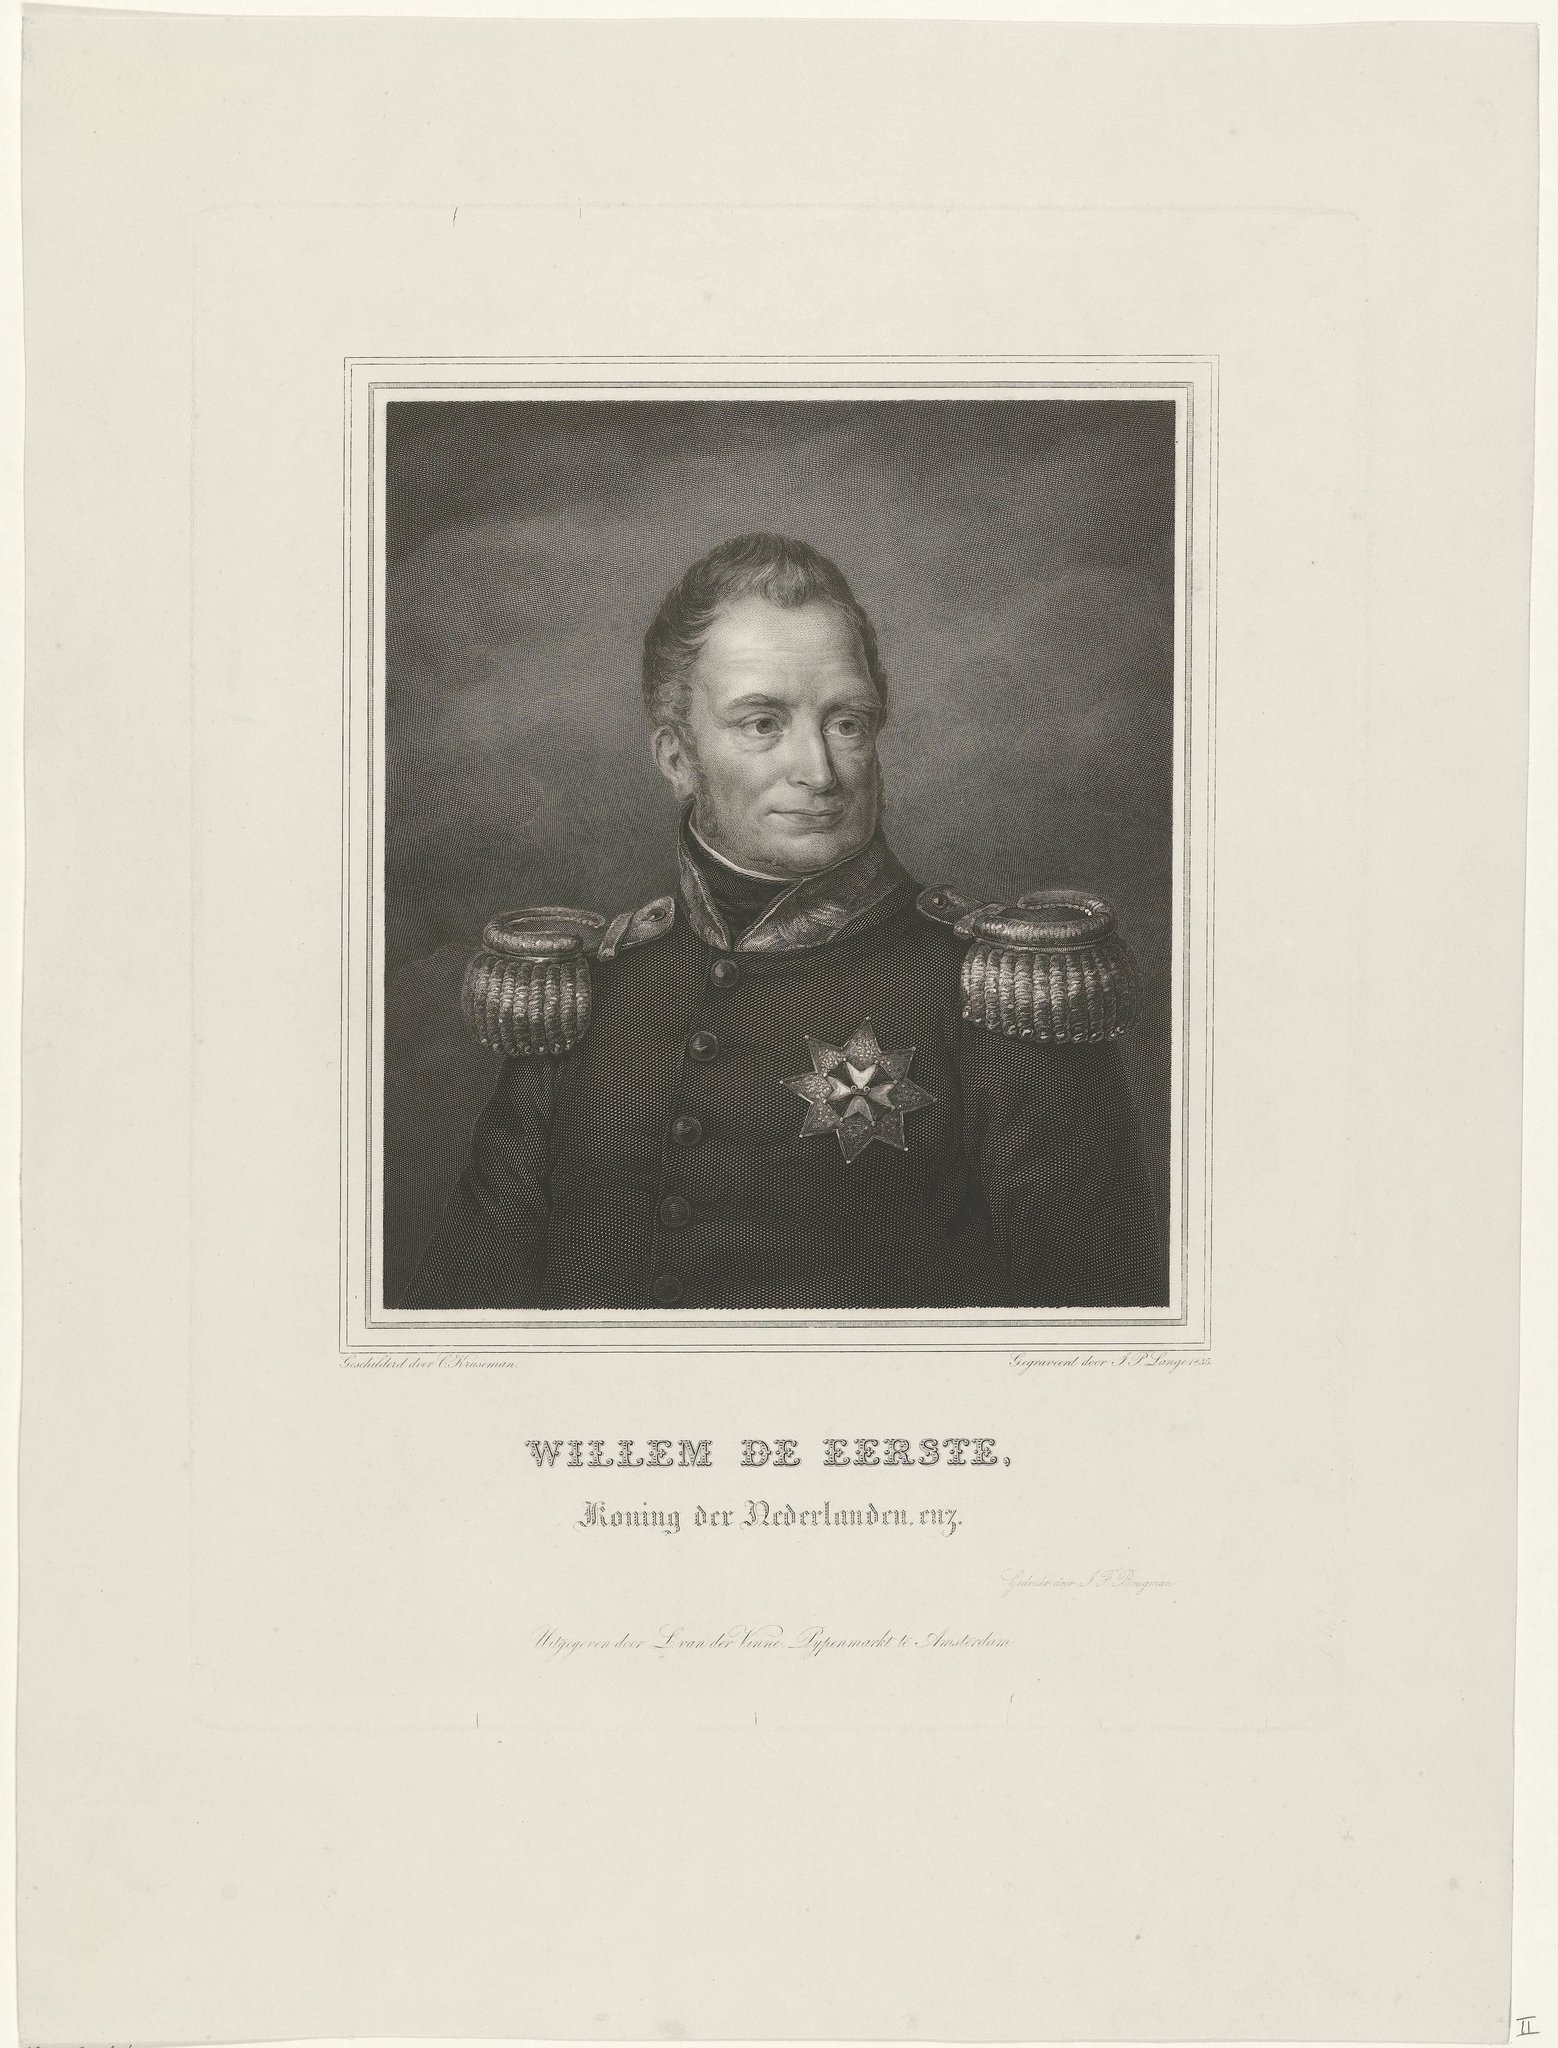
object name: print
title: Willem de Eerste, Koning der Nederlanden, enz.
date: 1835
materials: paper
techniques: engraving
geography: amsterdam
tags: william i of the netherlands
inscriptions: collector's mark: Lugt 2228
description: Portretbuste van Willem I Frederik, koning der Nederlanden, blootshoofds en gehuld in een uniform met ordester.